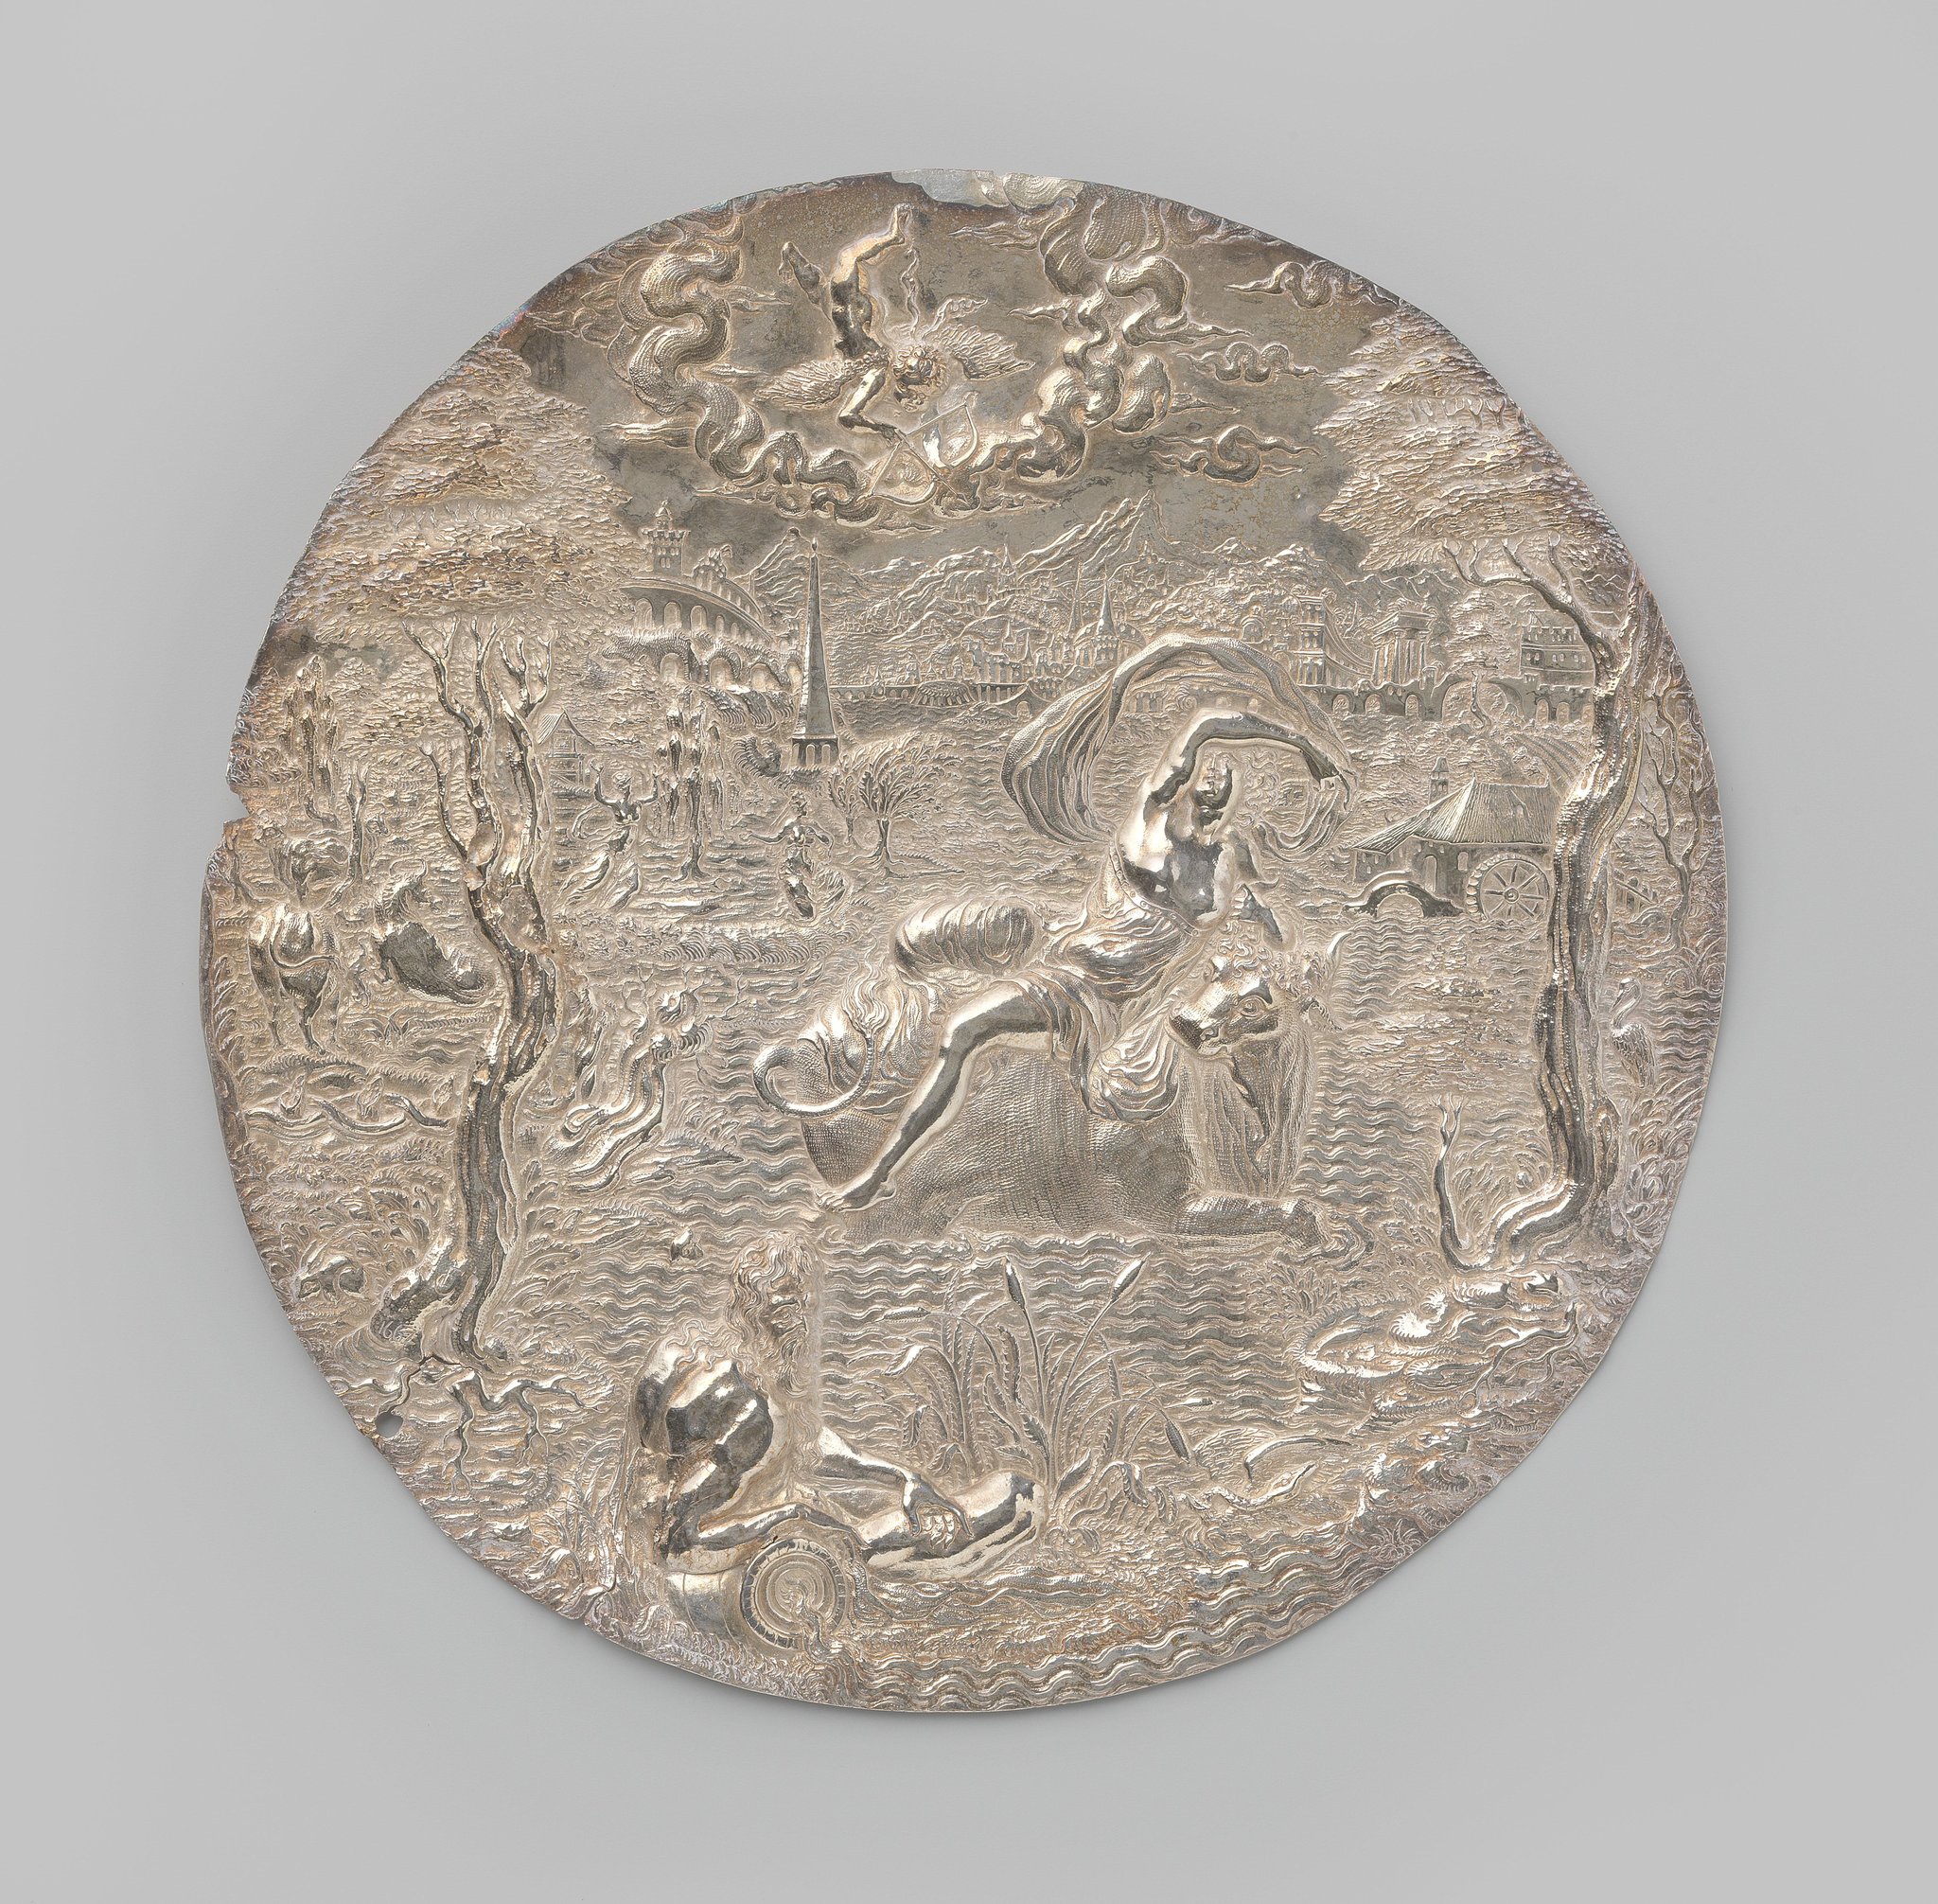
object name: plaque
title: De ontvoering van Europa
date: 1662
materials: silver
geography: nuremberg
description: Plaque with the Rape of Europe. Silver. Nuremberg, c. 1570.